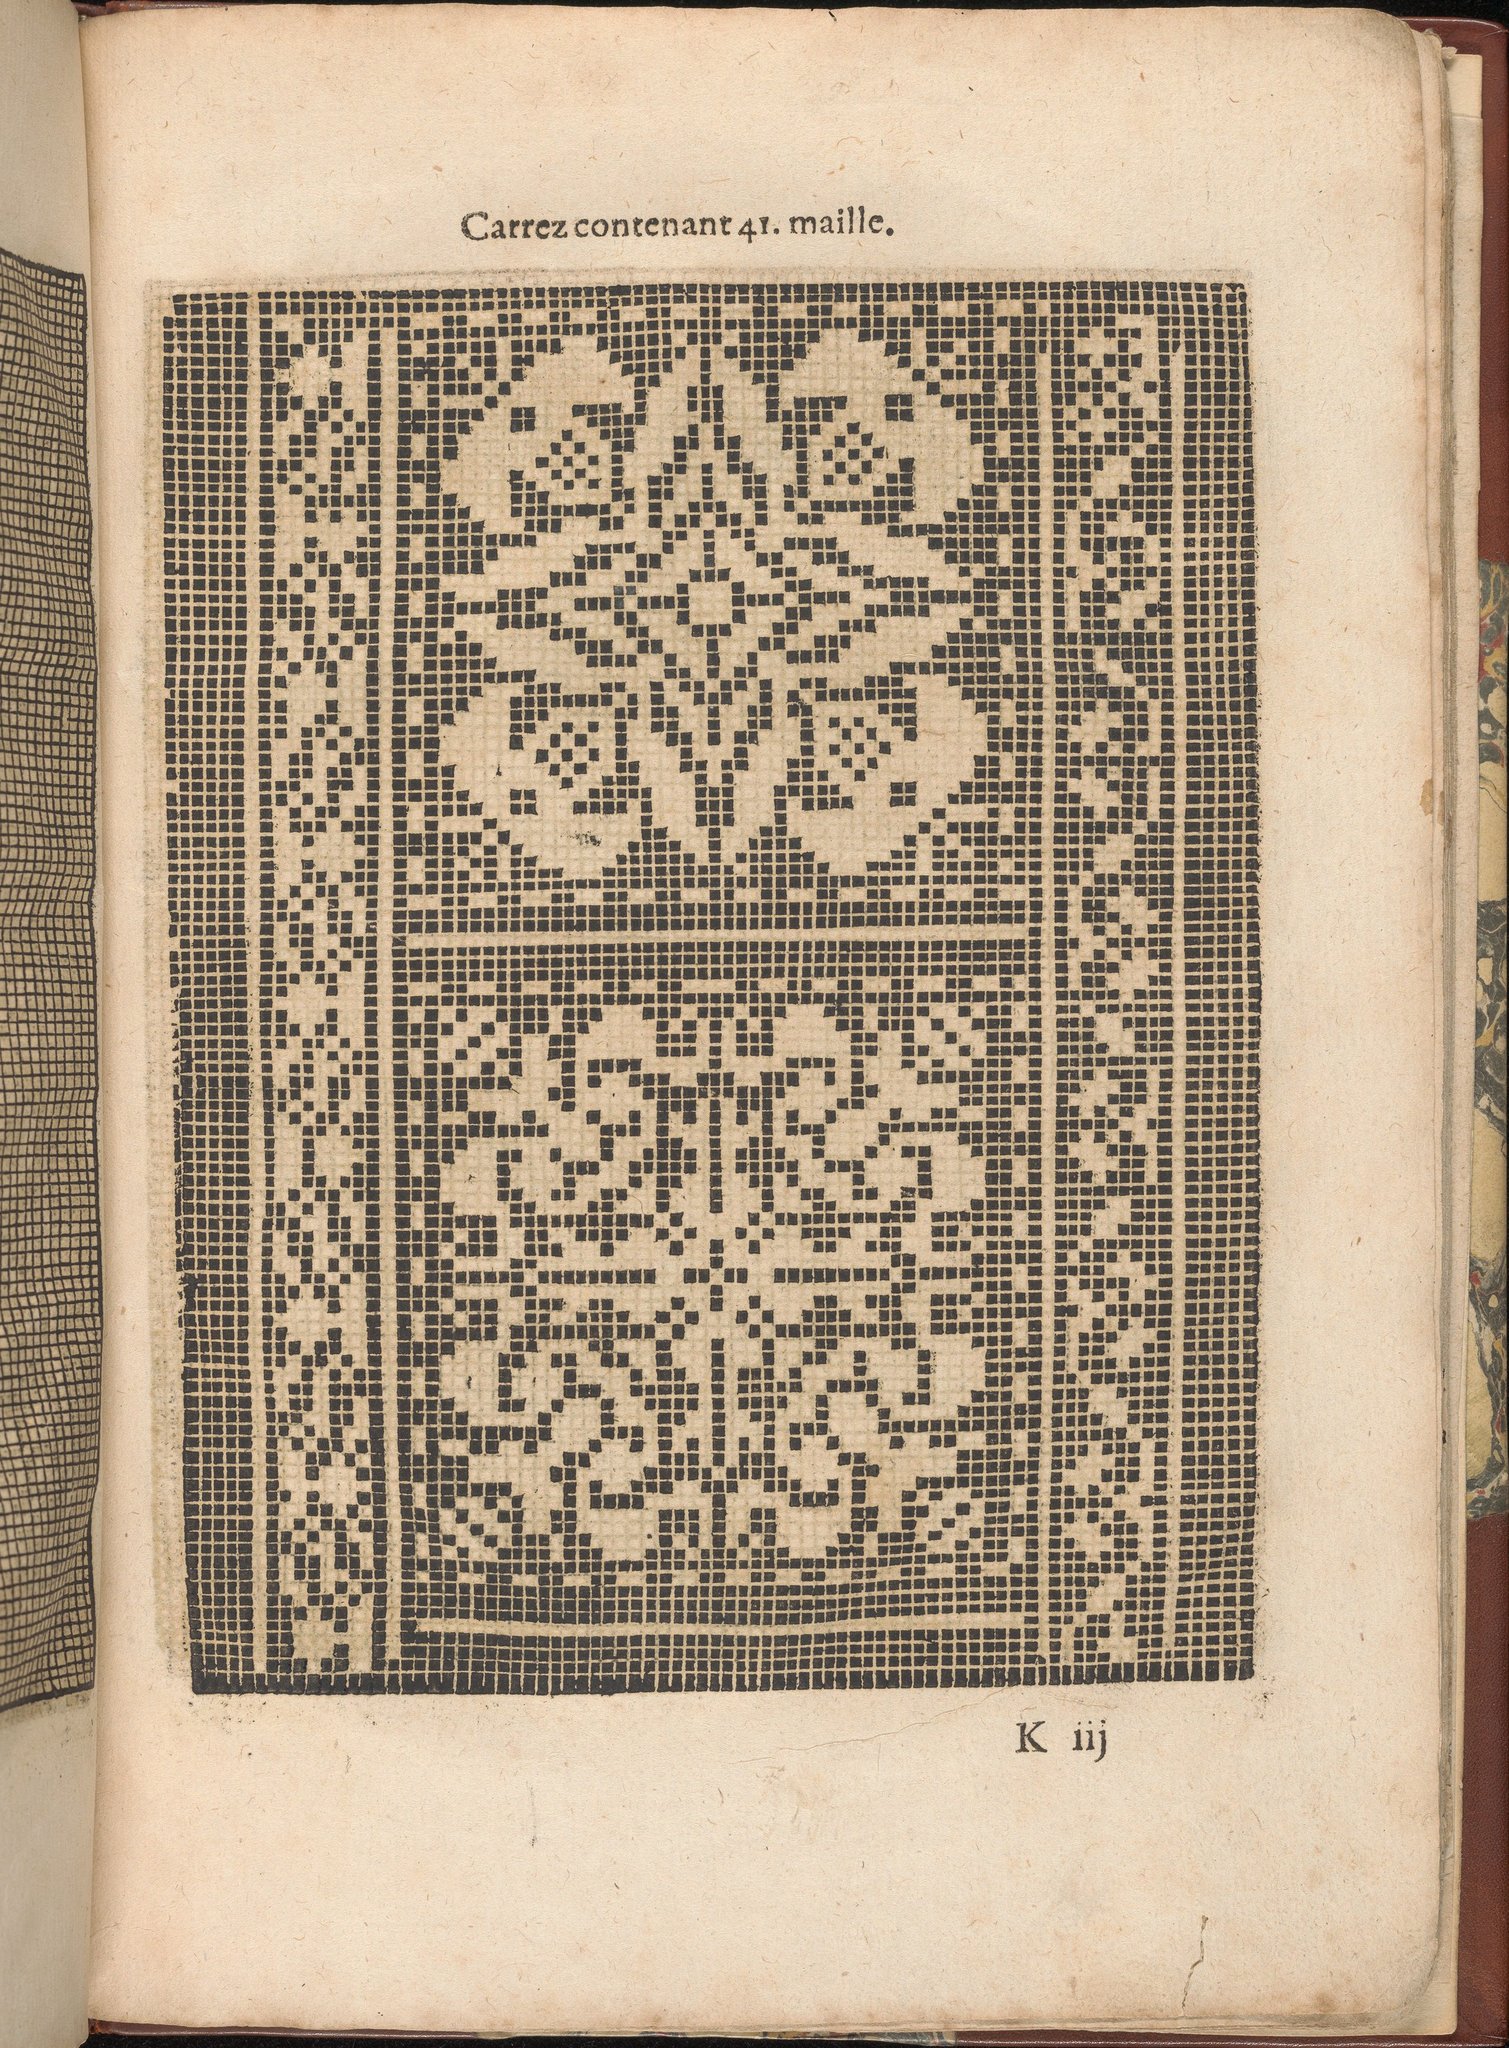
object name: book print ornament architecture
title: Les Secondes Oeuvres, et Subtiles Inventions De Lingerie du Seigneur Federic de Vinciolo Venitien, page 39 (recto)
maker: federico de vinciolo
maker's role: designer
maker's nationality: italian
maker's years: 1582-1599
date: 1603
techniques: woodcut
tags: ornament